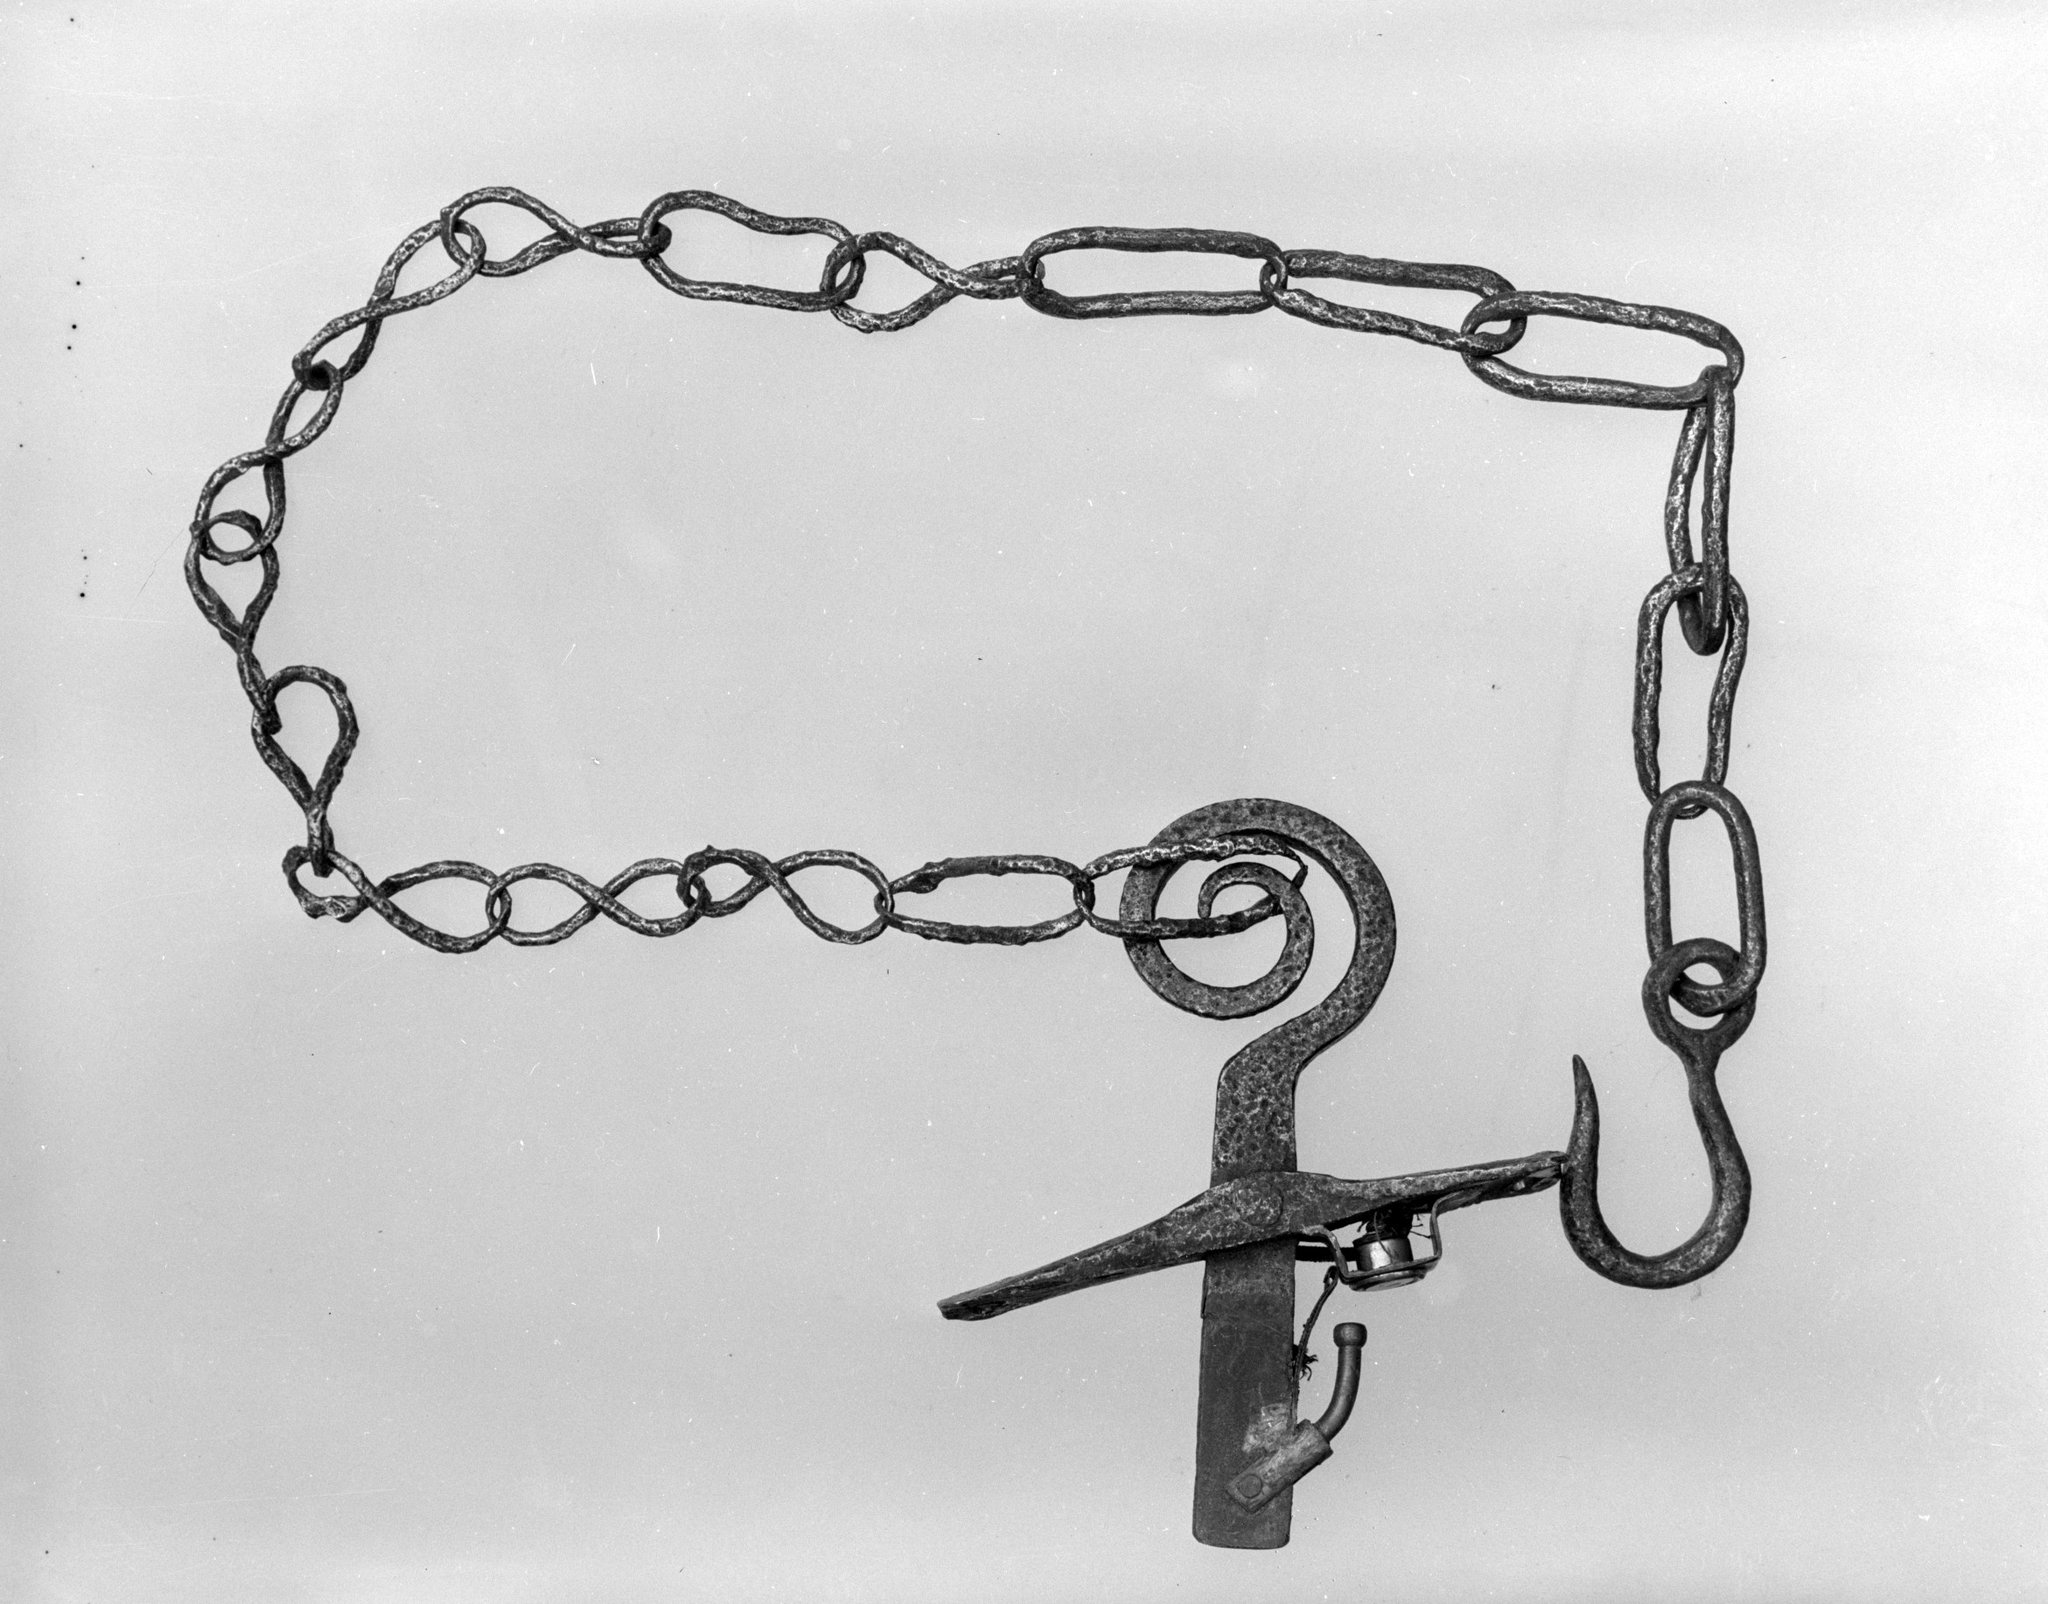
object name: latch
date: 1700-1800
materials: iron